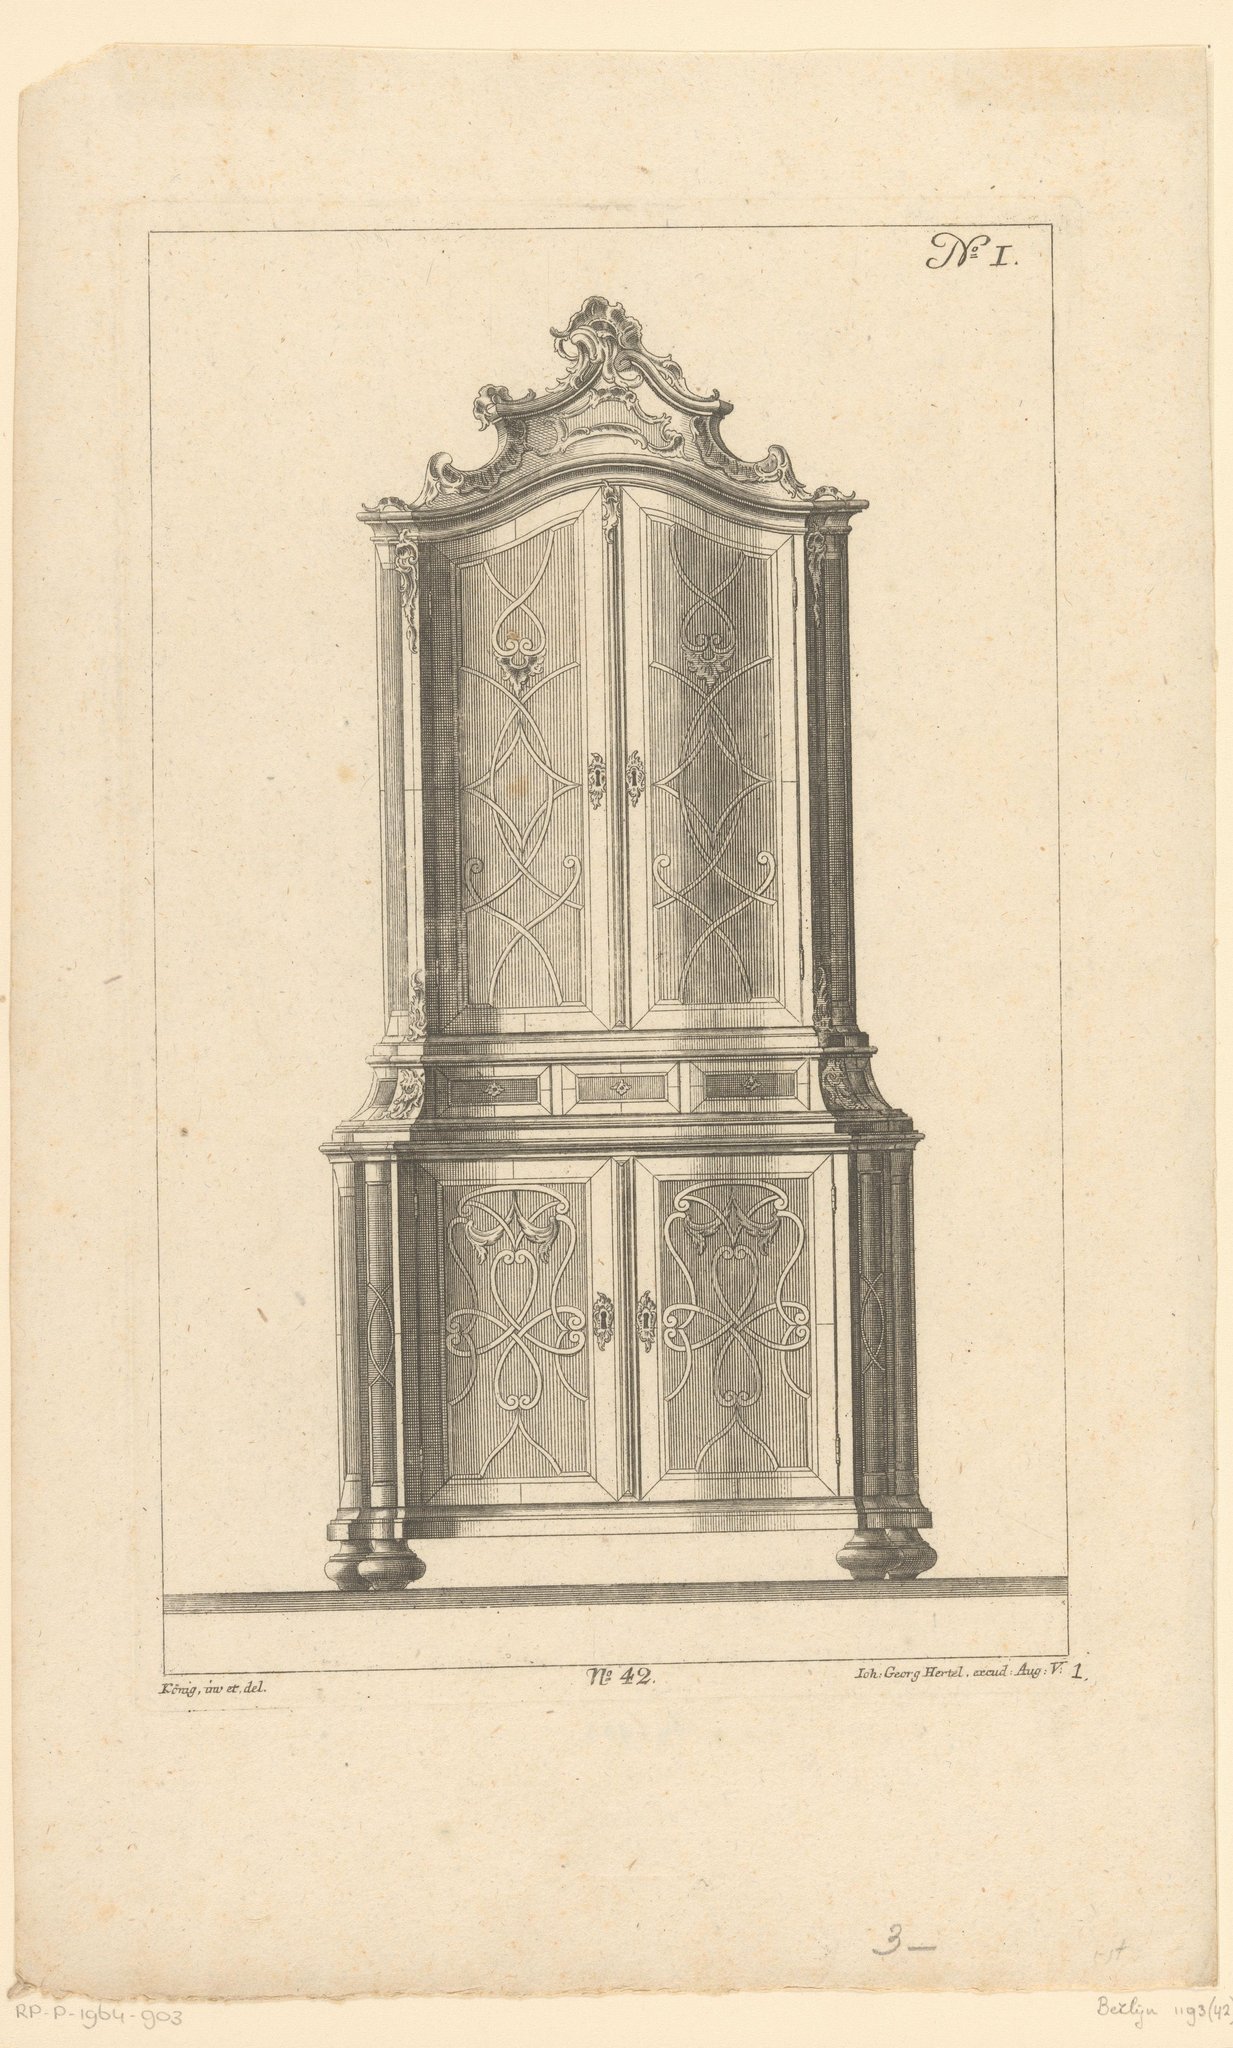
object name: ornament print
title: Kast met rocaille ornamenten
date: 1705-1775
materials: paper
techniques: engraving, etching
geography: augsburg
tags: ornamental cupboard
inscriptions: collector's mark: Lugt 2760, collector's mark: Lugt 2228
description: Ontwerp voor een kast met twee deuren onder en boven en drie lades in het midden. Gedecoreerd met rocaille ornamenten. Uitgeversnummer 42.